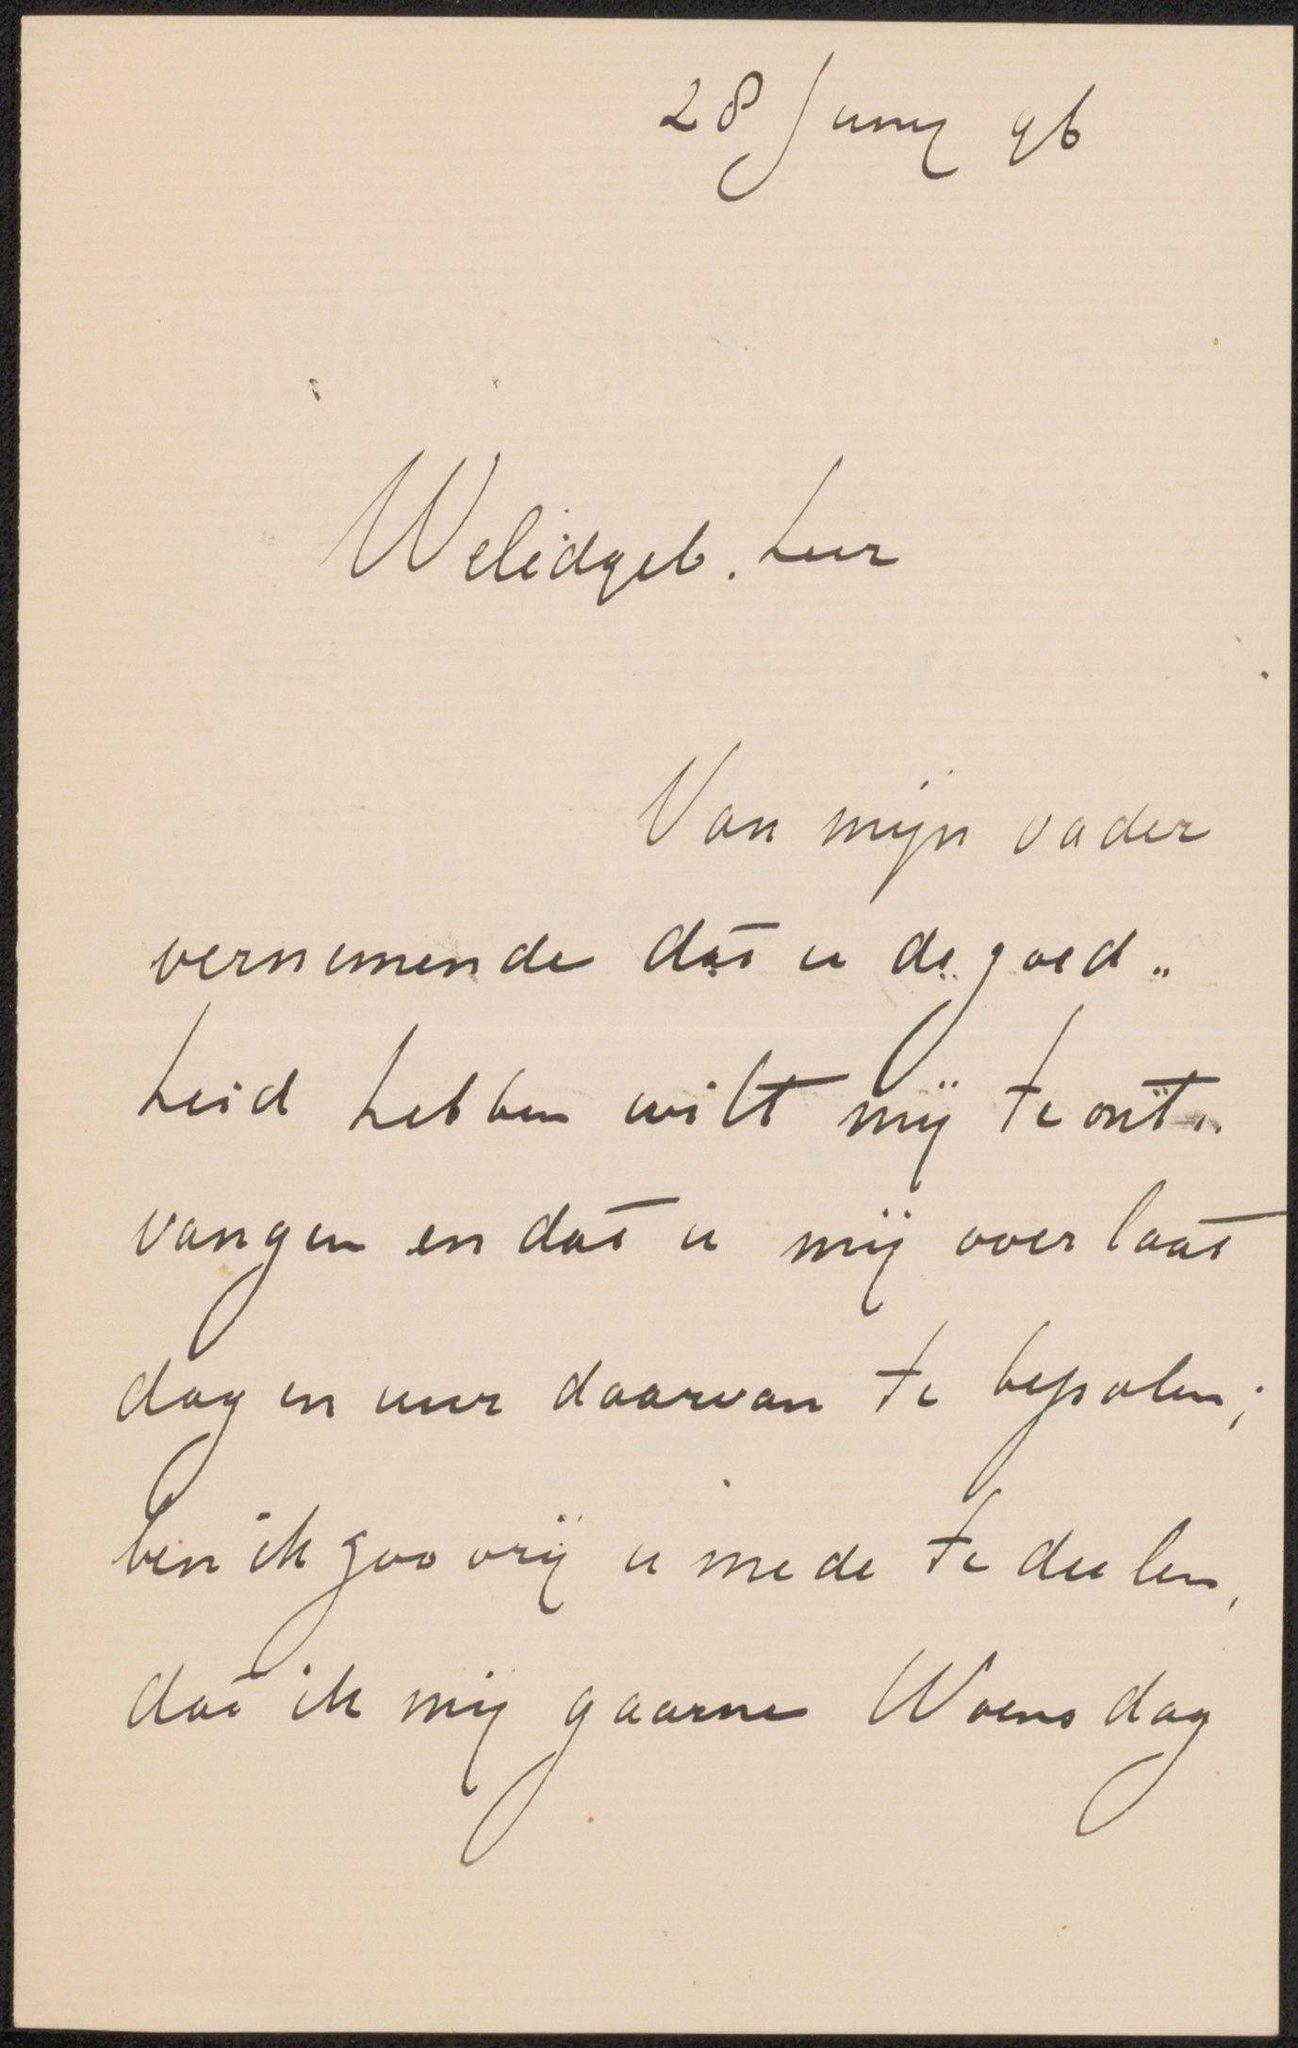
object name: letter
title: Brief aan August Allebé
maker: henry adriaan haverkorn van rijsewijk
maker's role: draughtsman, painter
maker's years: 1868-1945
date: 1896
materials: ink, paper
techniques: pen, writing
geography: rotterdam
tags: amsterdam, print maker, draughtsman, august allebé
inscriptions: watermark